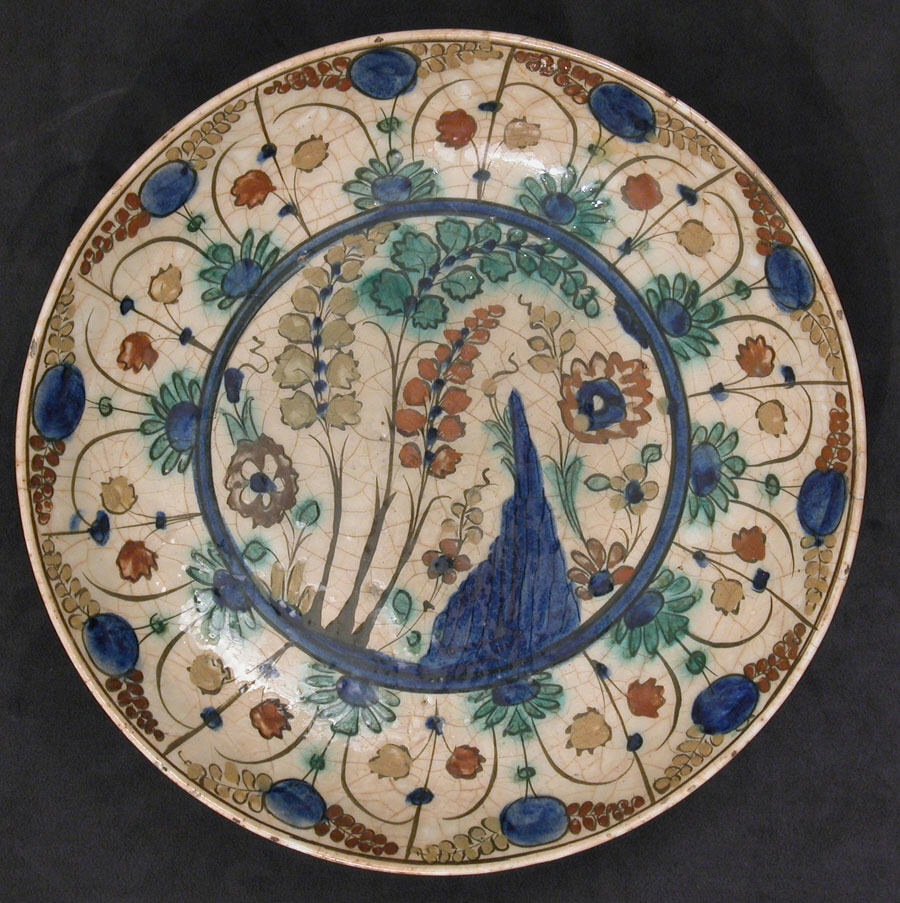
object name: dish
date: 1601-1700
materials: stonepaste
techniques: painting, underglaze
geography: iran